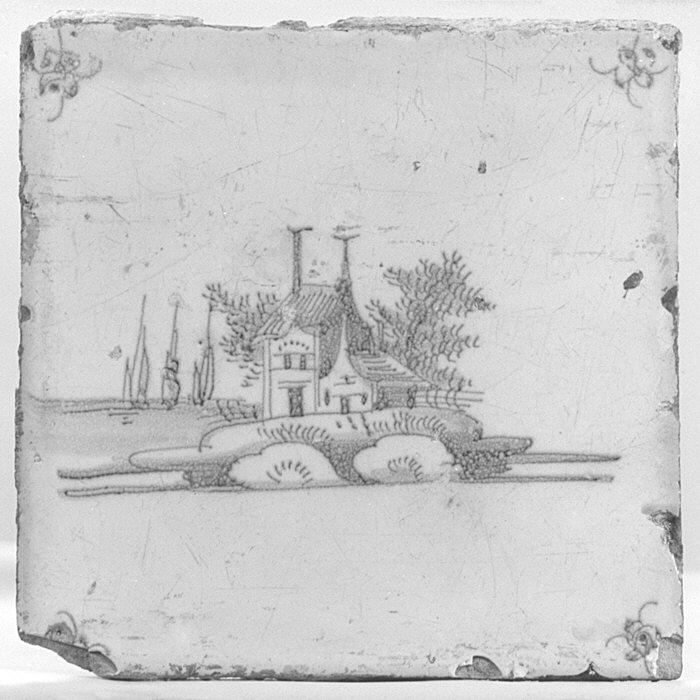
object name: tile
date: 1701-1733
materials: earthenware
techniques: glazing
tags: houses,trees